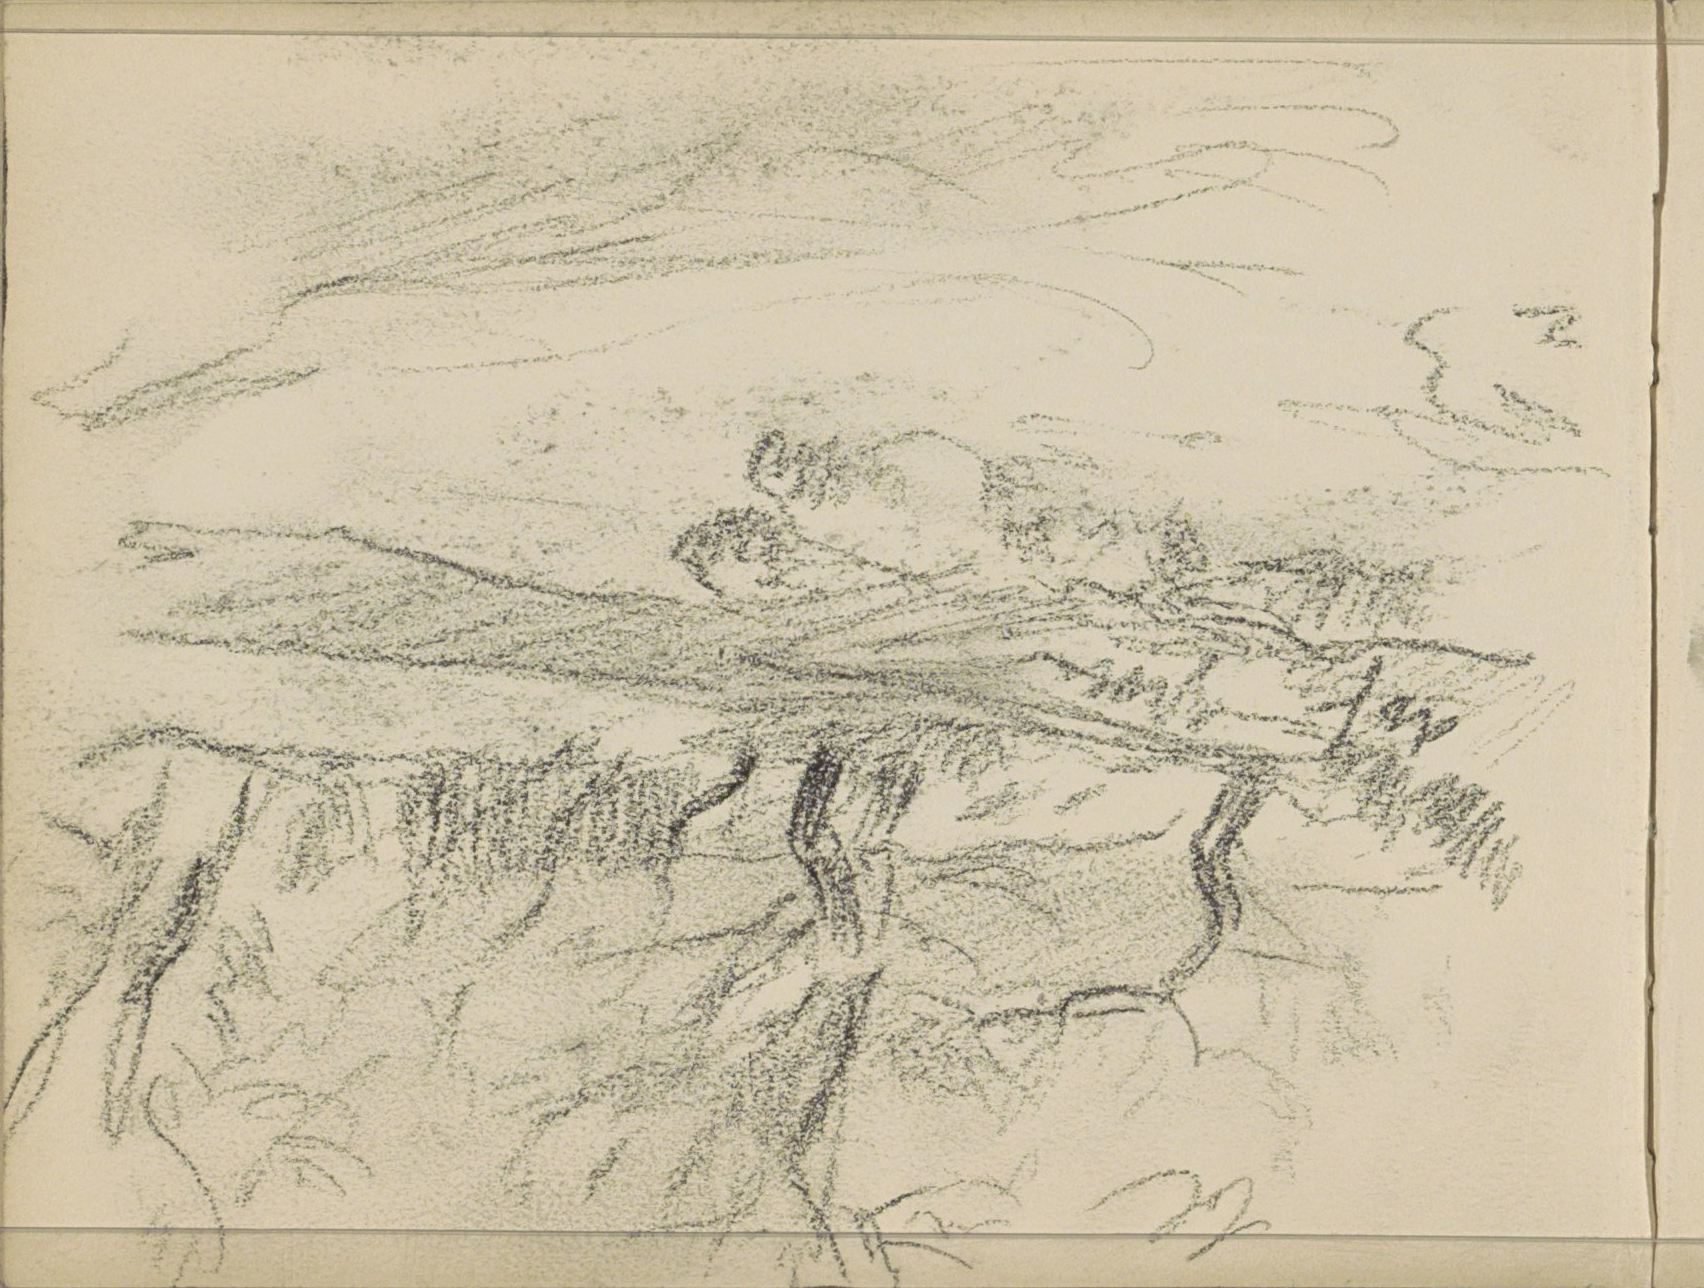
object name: sketchbook leaf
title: Landschap met bomen, mogelijk een duinlandschap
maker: johan antonie de jonge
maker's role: draughtsman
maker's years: 1864-1927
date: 1881-1927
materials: chalk, paper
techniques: stumping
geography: south holland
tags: dune coast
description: Landschap met bomen, mogelijk een duinlandschap. Blad 25 verso uit een schetsboek met 34 bladen.